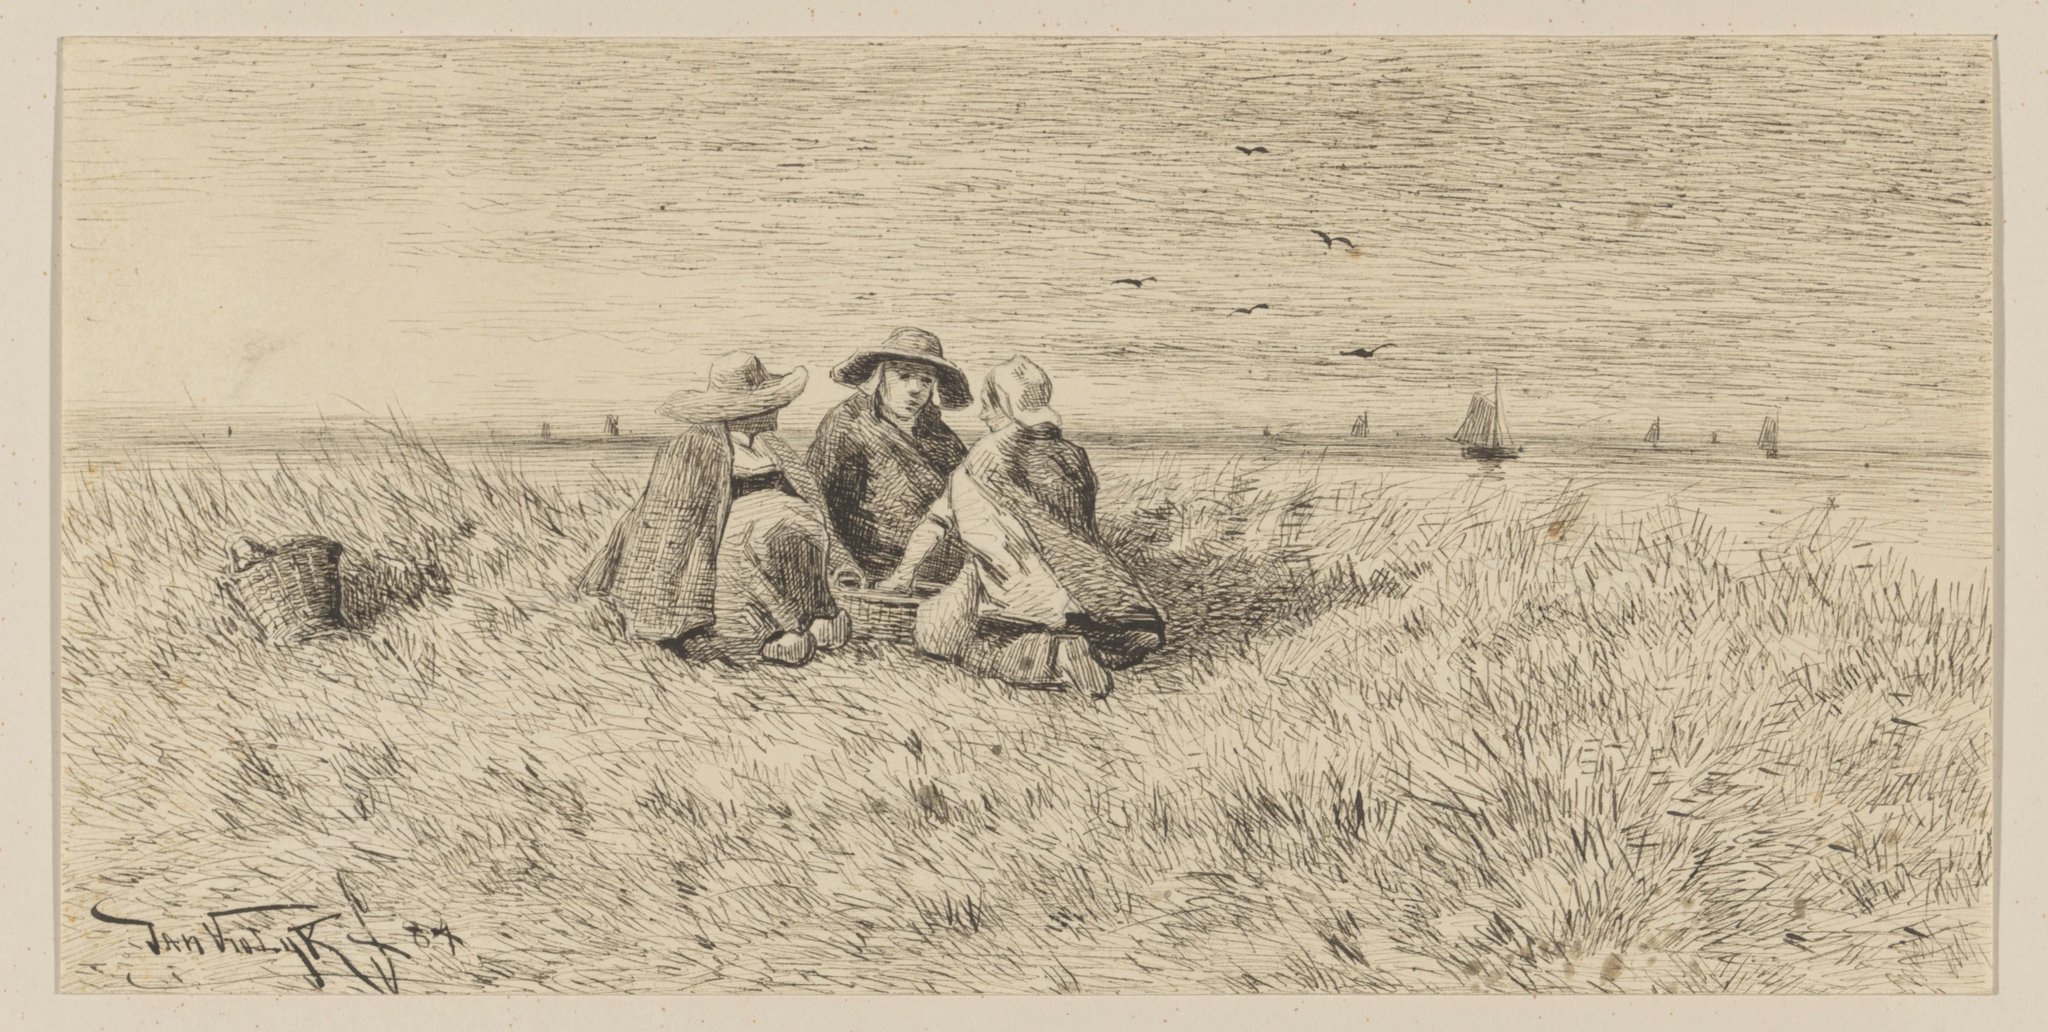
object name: drawing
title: Drie Scheveningsche vrouwen in de duinen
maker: jan vrolijk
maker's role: draughtsman, painter, print maker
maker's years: 1846-1894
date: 1884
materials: ink, paper, pencil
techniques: pen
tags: sitting figure - aa - female human figure, dunes (sea not visible); in the dunes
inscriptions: date: ‘84’